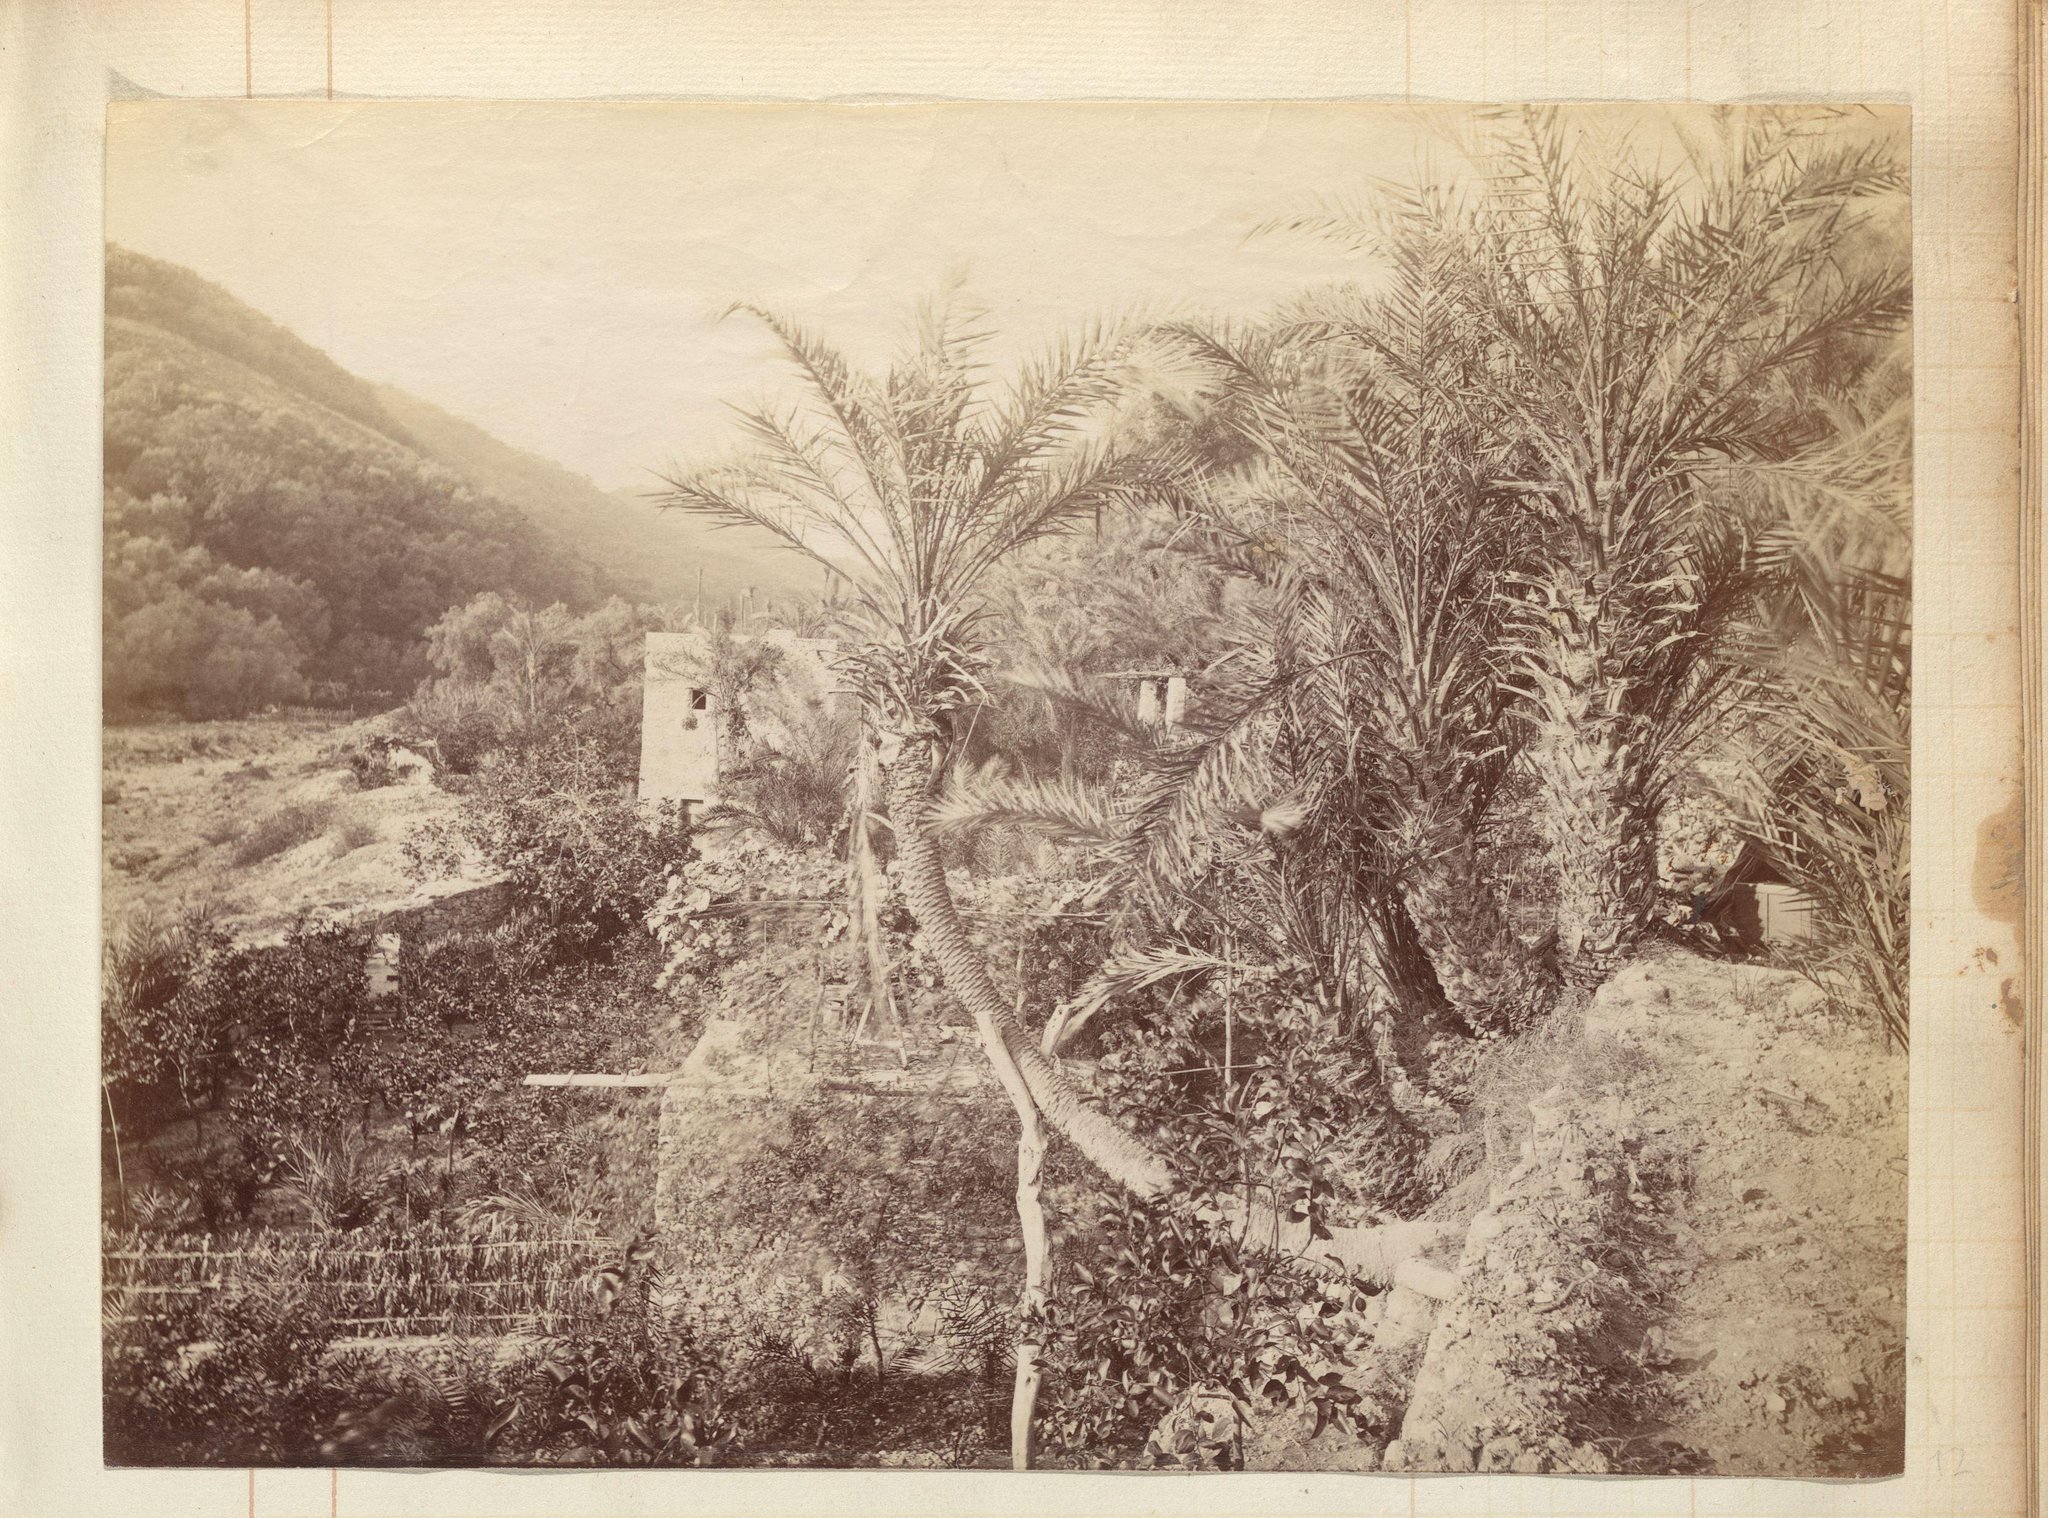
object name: photograph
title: Landschap met palmbomen en heuvels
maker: Anonymous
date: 1880-1900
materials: paper, photographic support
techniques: albumen print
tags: landscapes in tropical and sub-tropical regions